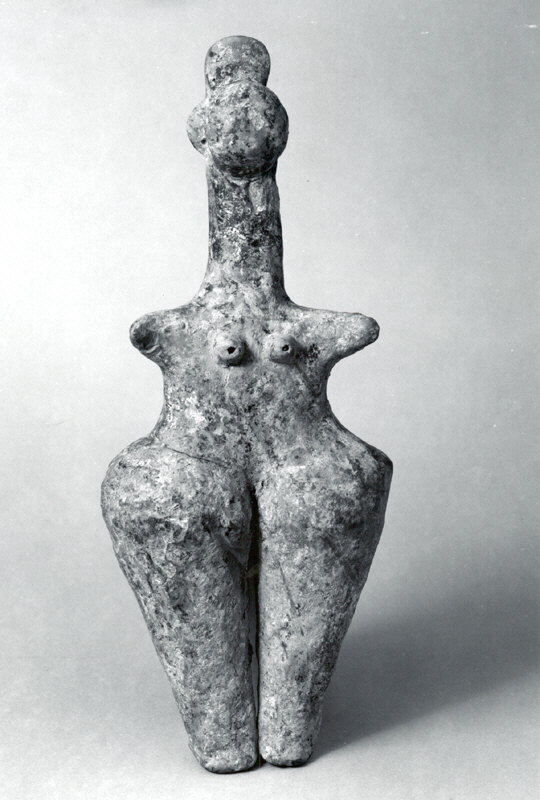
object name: sculpture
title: Figurine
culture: iranian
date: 1000-1 BCE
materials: ceramic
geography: northwestern iran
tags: female nudes